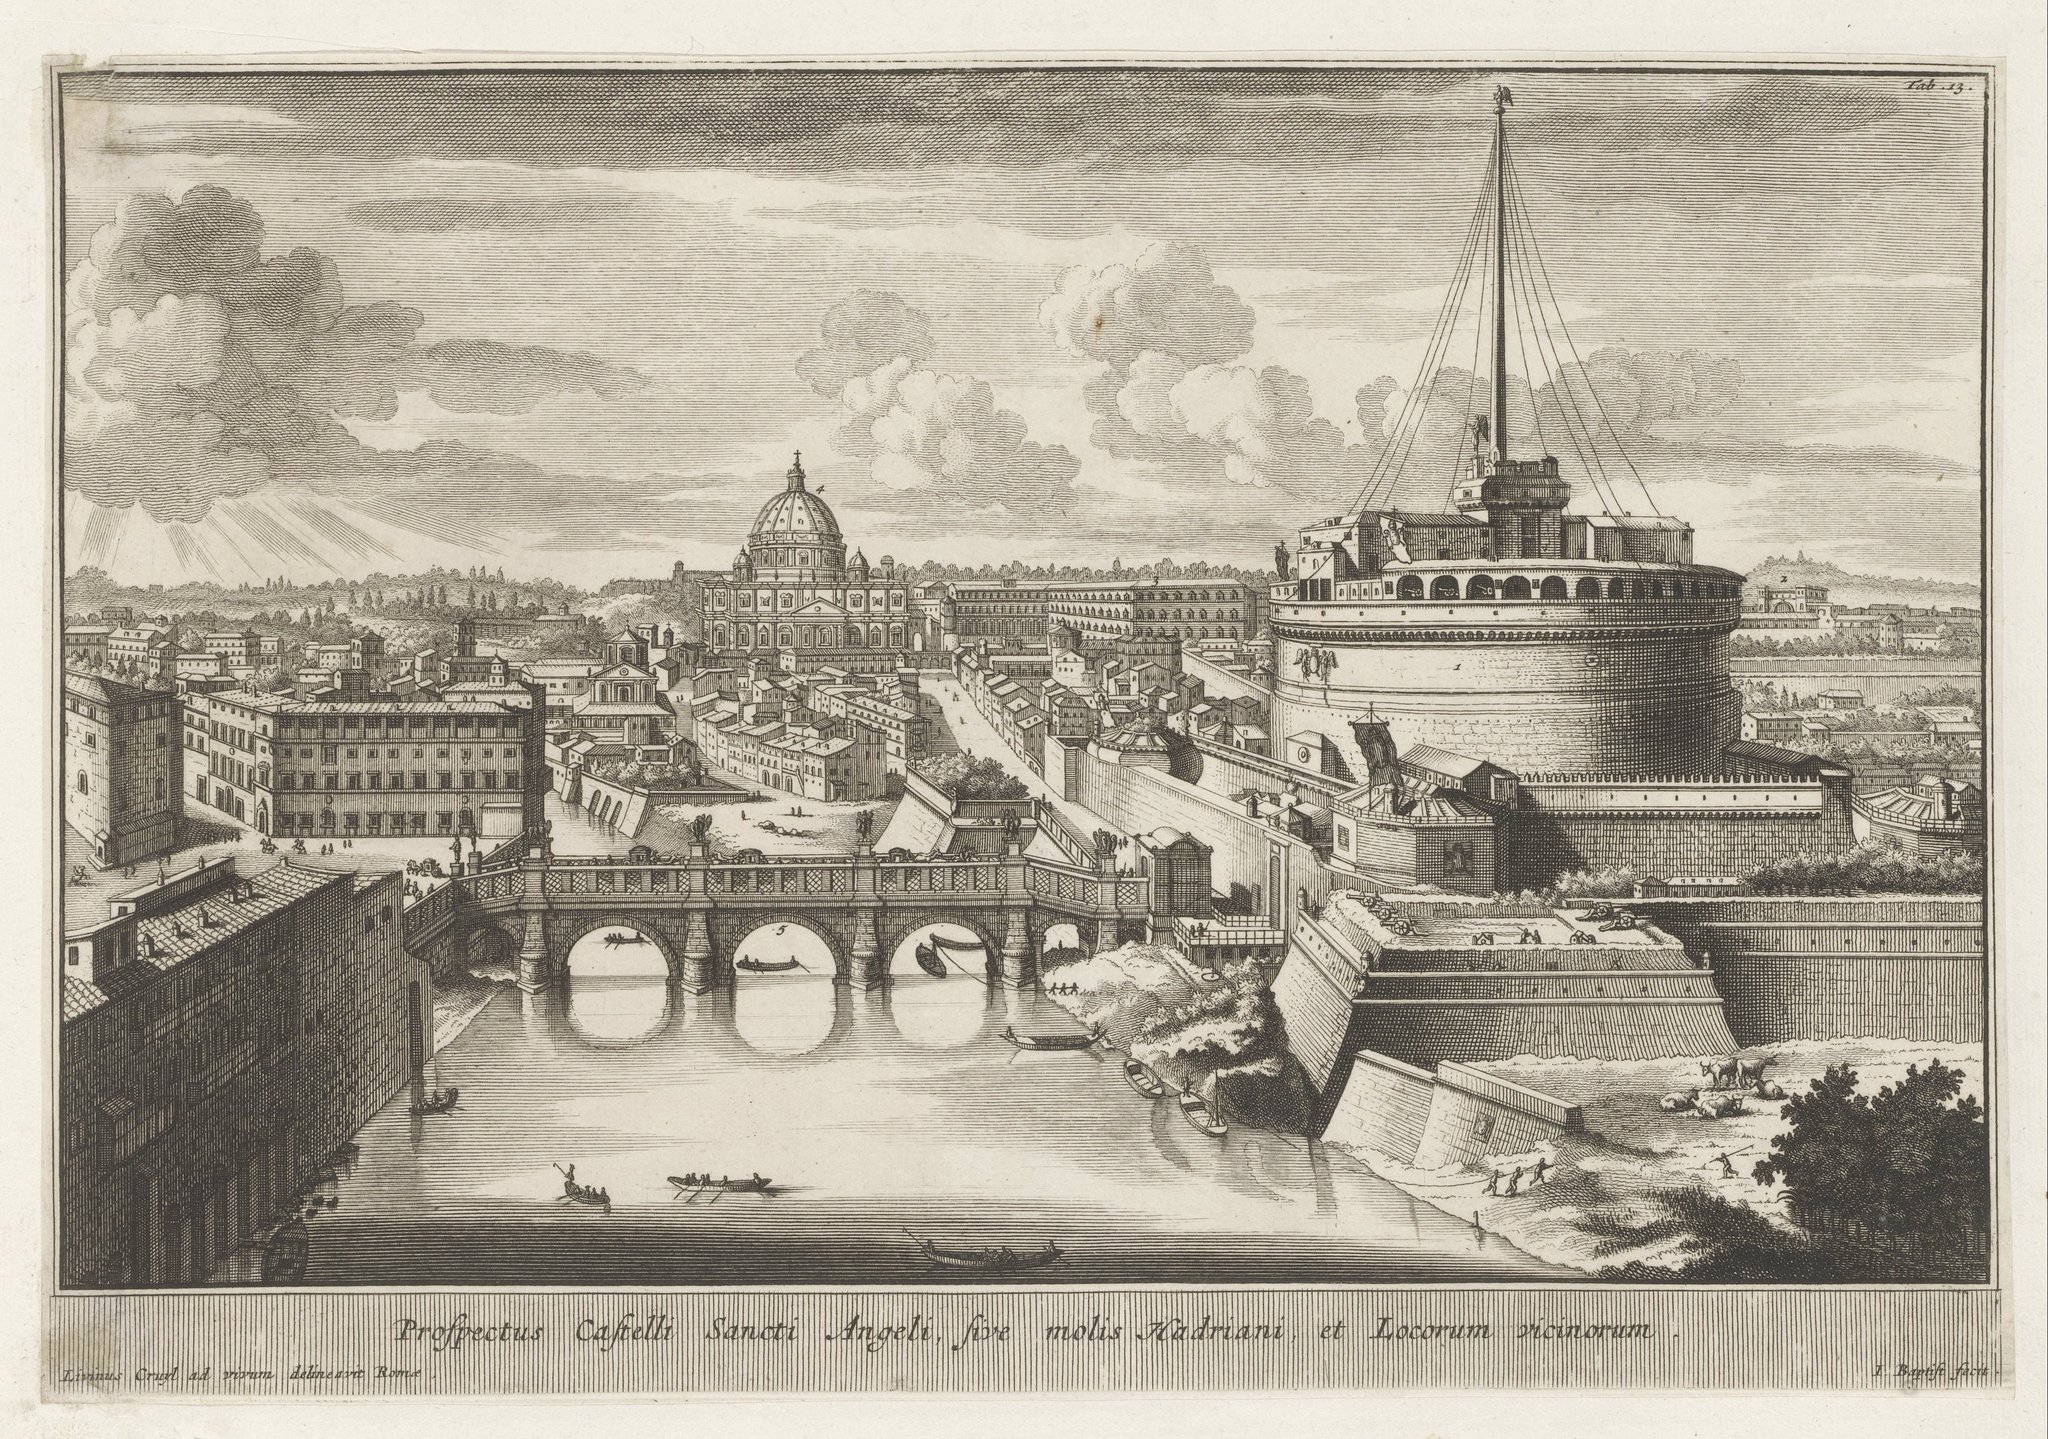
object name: album leaf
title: La Galerie agreable du mond (...) divisée en LXVI tomes...Cette partie comprend le Rome moderne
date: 1729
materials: paper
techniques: etching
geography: amsterdam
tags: city-view, and landscape with man-made constructions, church (exterior), bridge in city across river, canal, etc.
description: Deze voorstelling is geknipt uit een blad met twee prenten, met in totaal drie voorstellingen. De twee andere voorstellingen betreffen een fontein op Piazza Navona en de Chiesa di San Pietro Apostolo.